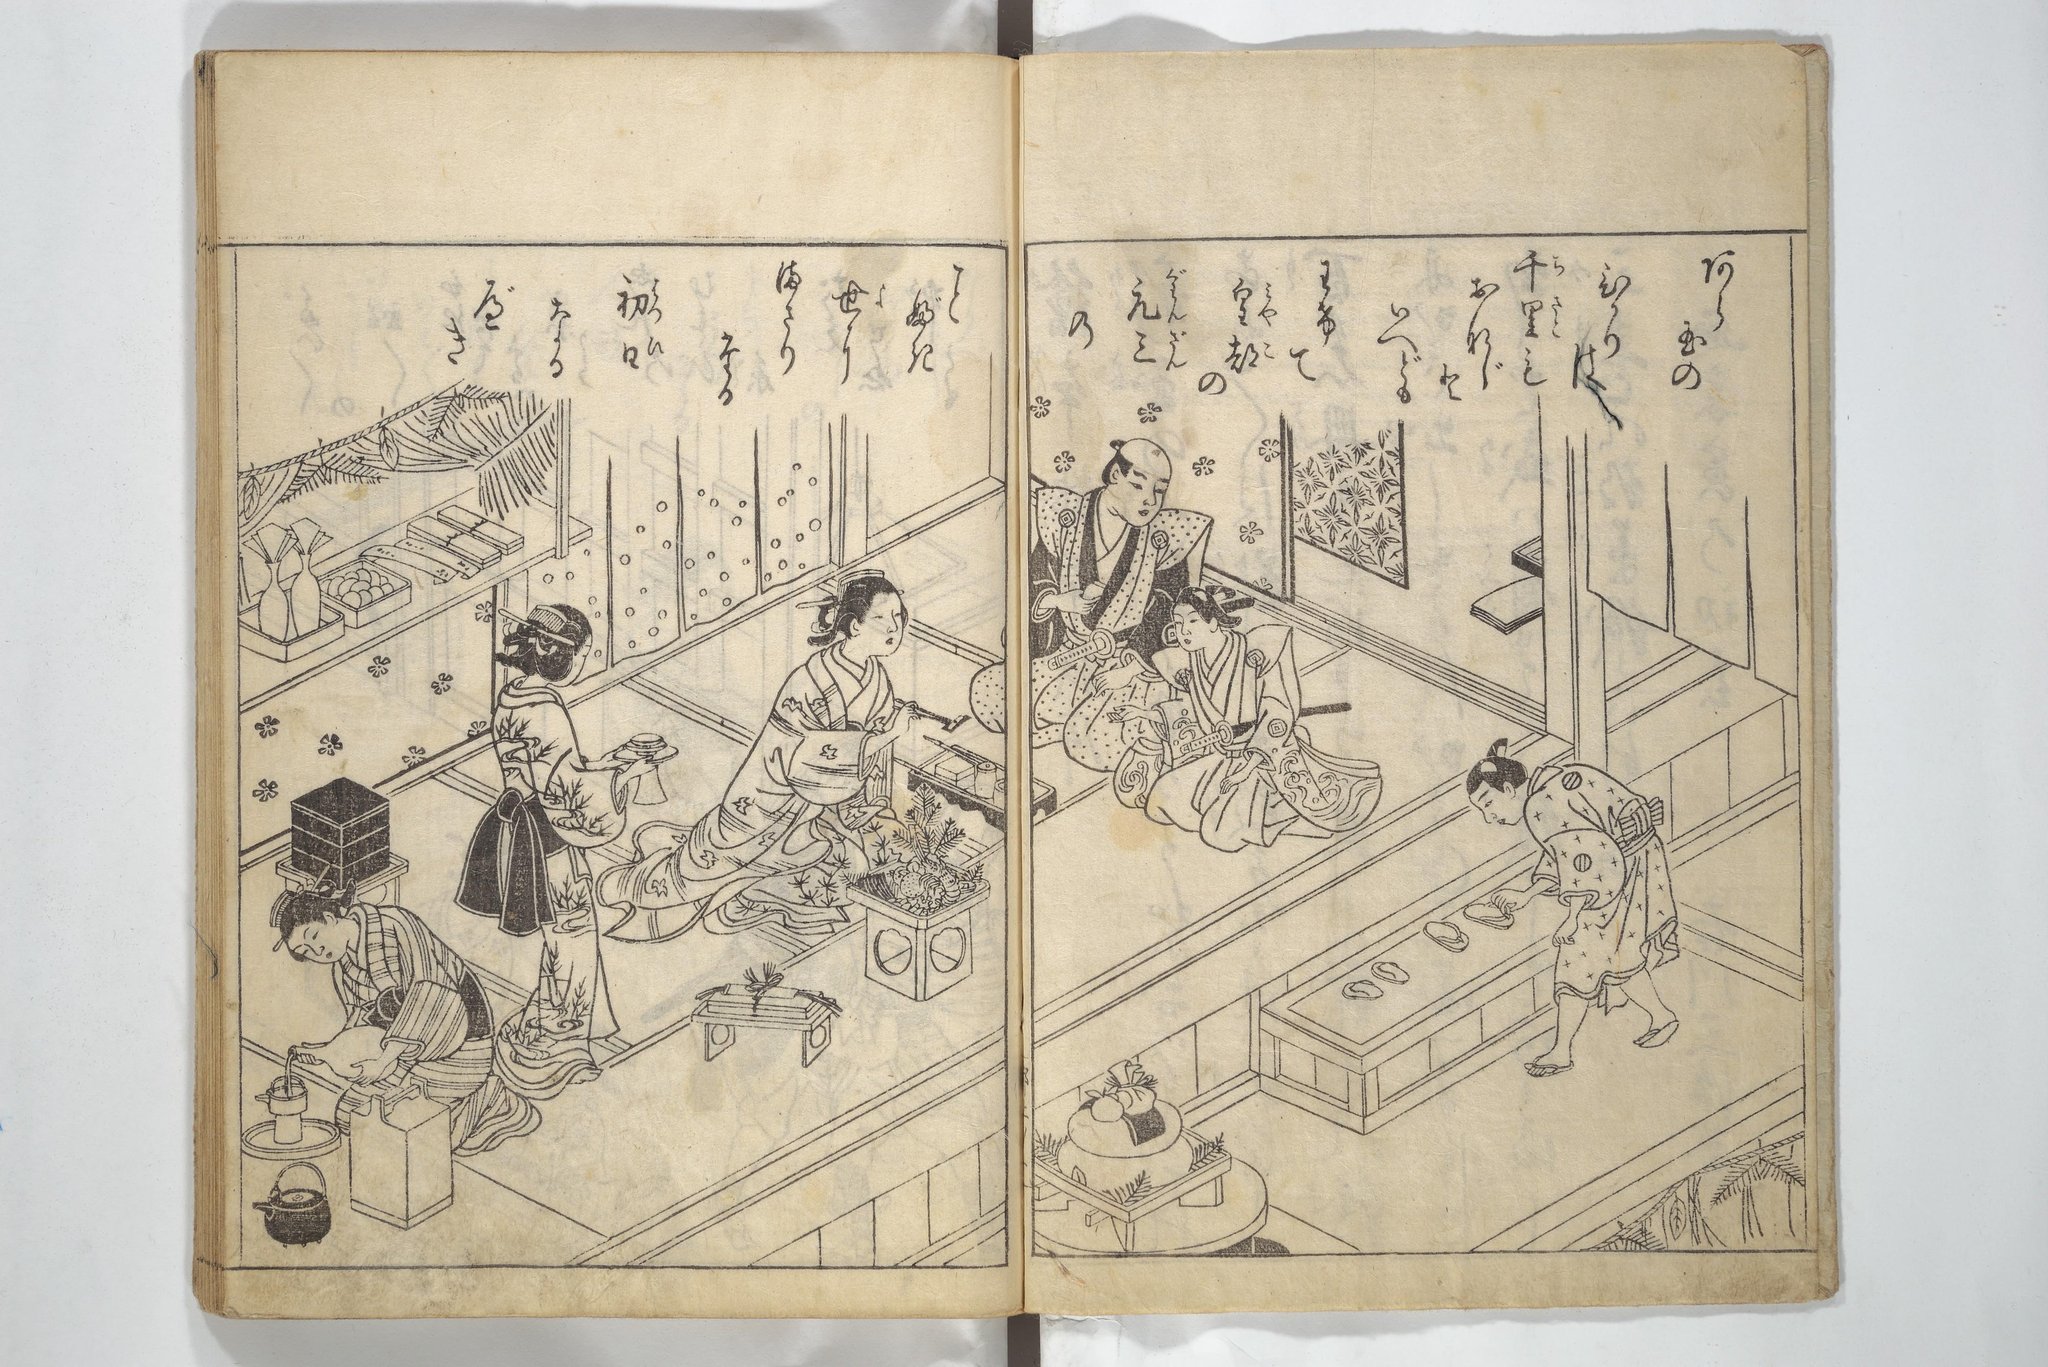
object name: illustrated book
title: Picture Book of Life in the Capital (Ehon miyako zōshi) 絵本都草紙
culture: japanese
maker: nishikawa sukenobu 西川祐信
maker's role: artist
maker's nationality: japanese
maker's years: 1671-1750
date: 1746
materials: ink, paper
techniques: woodblock print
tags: men,women,working